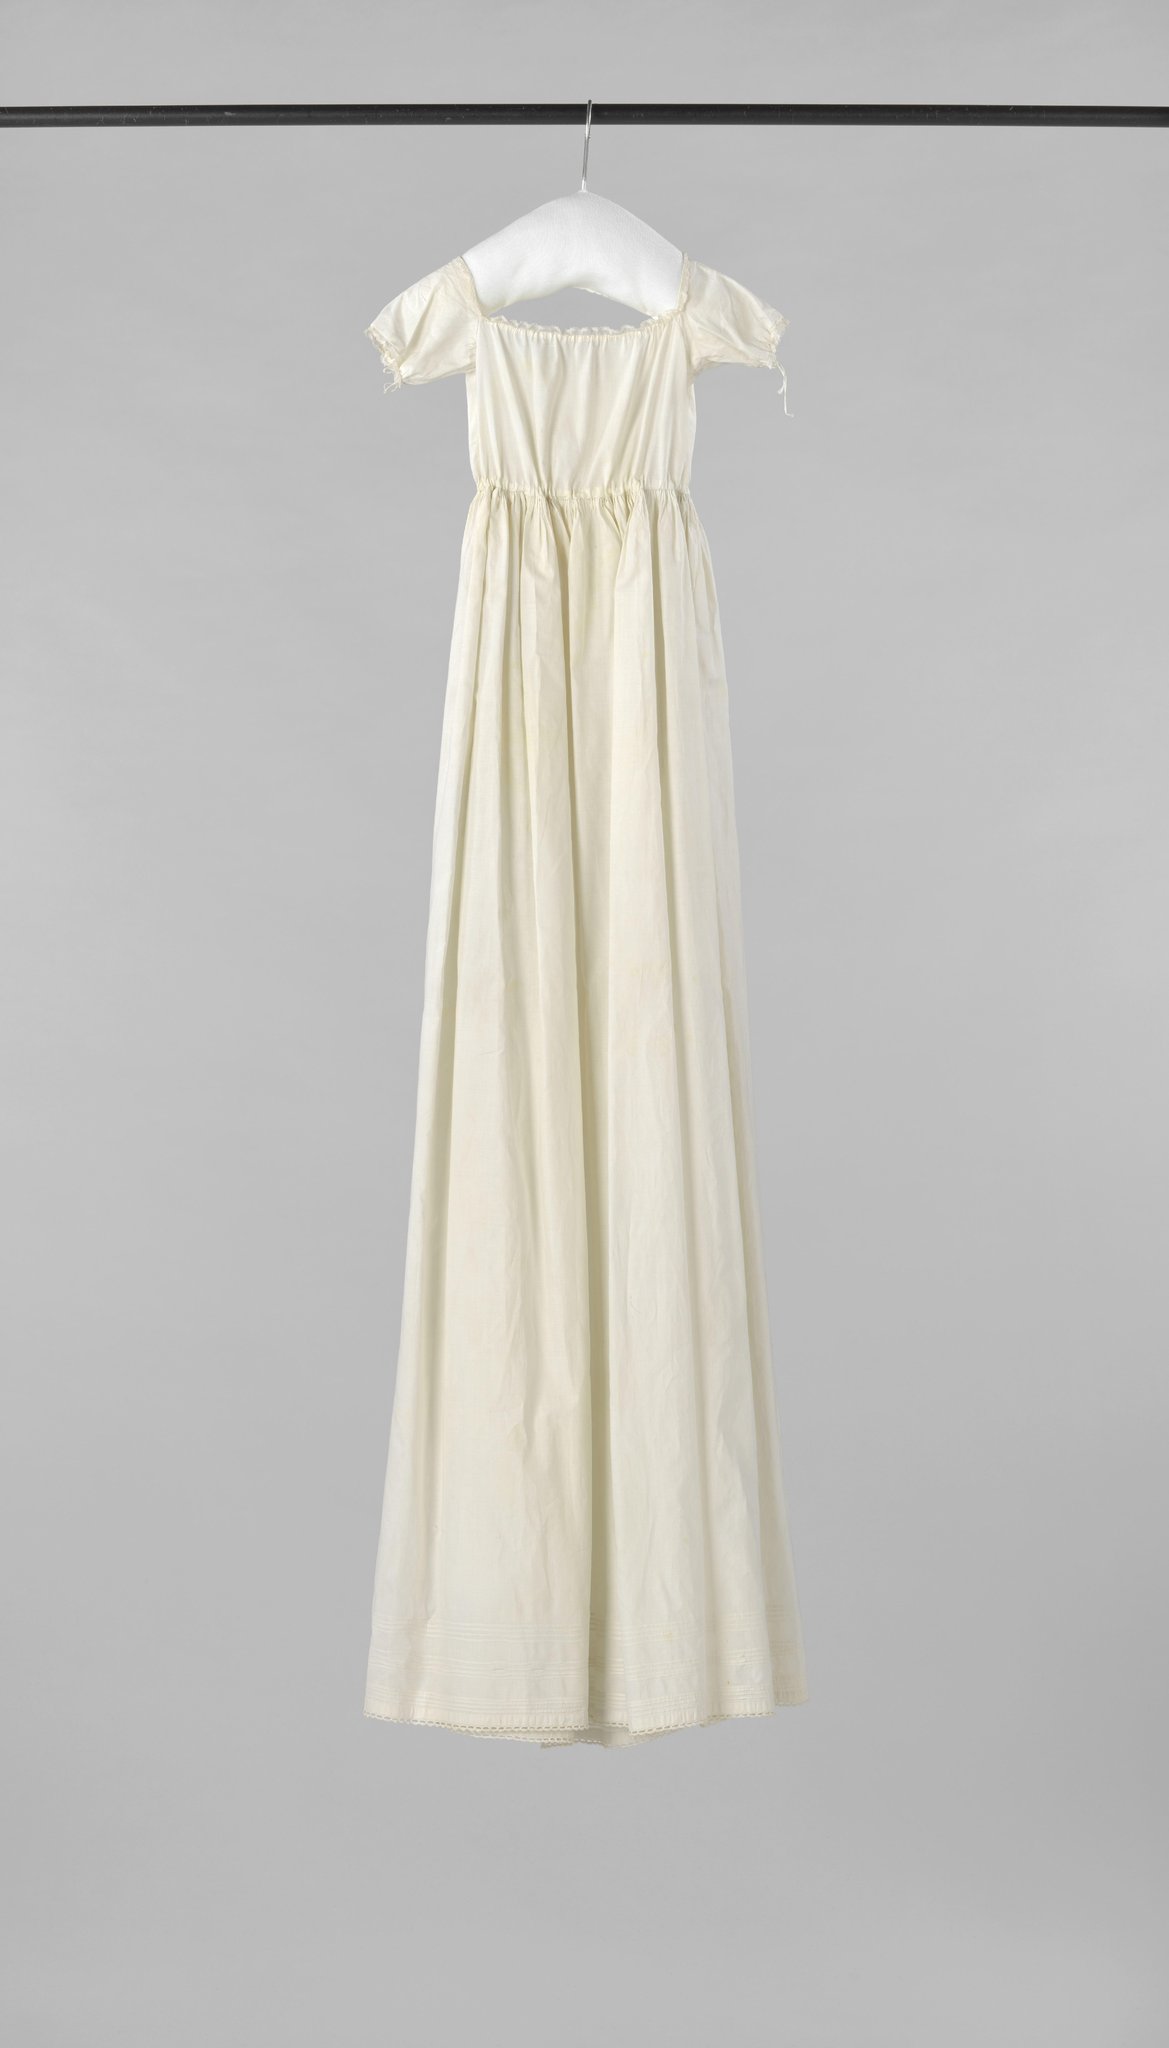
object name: boys' wear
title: Baby-onderjurk van een 'lange jurk', van fijn katoen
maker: Anonymous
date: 1850-1900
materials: cotton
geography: amsterdam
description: Baby-onderjurk voor een "lange jurk", van fijn katoen, bovenaan versierd met kant en oprijgjes. Rood gemerkt S.4-voor:Six. Second empire. Model: Handgenaaid. Recht lijfje met vierkante enkorte mouwtjes. Ruim gerimpelde rechte rok. Versiering: Langs de hals en de mouwtjes loopt een smal valenciennetje. Onderaan een galon met geborduurd boogjes en nulletjes. Drie rijen fijne oprijgjes. Toestand. In 1979 gewassen.